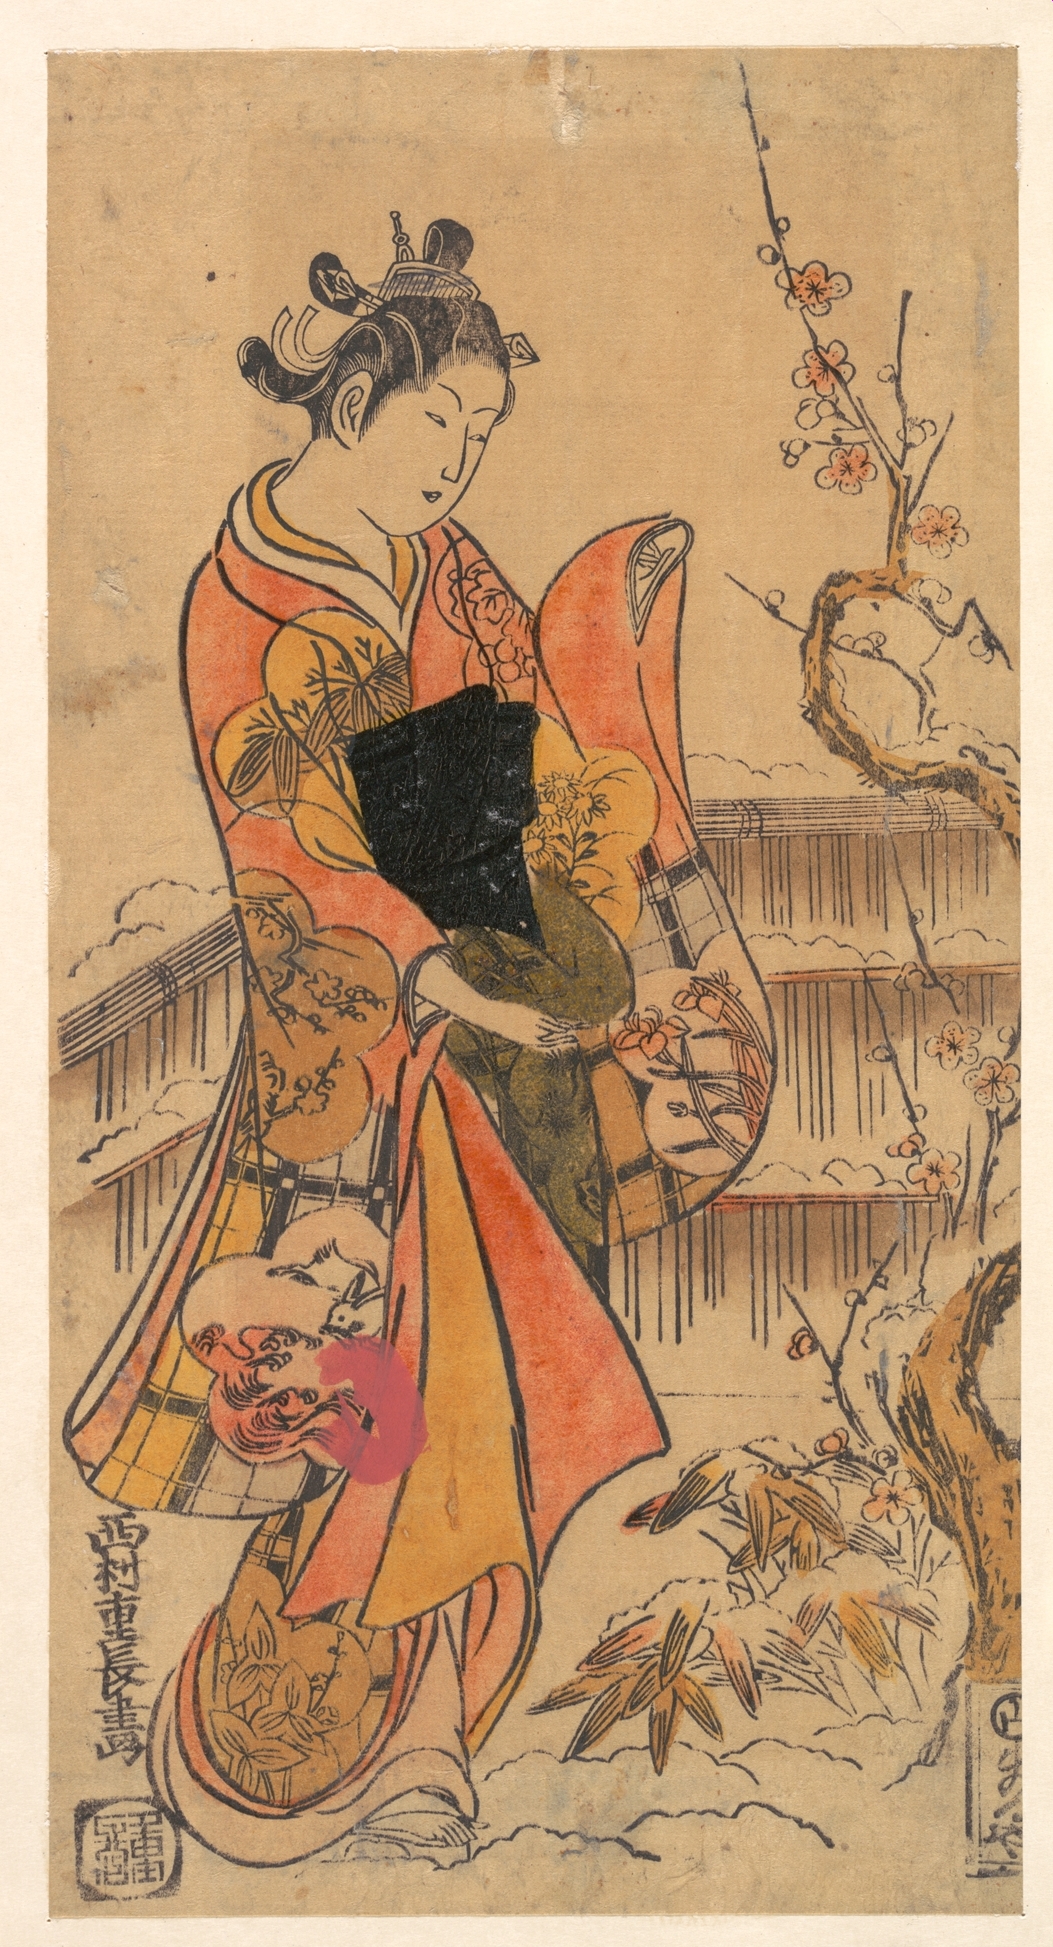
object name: print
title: A Young Lady in a Garden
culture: japanese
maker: nishimura shigenaga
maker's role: artist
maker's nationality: japanese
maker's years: 1697-1756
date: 1697-1756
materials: ink, paper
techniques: woodblock print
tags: gardens,women,flowers